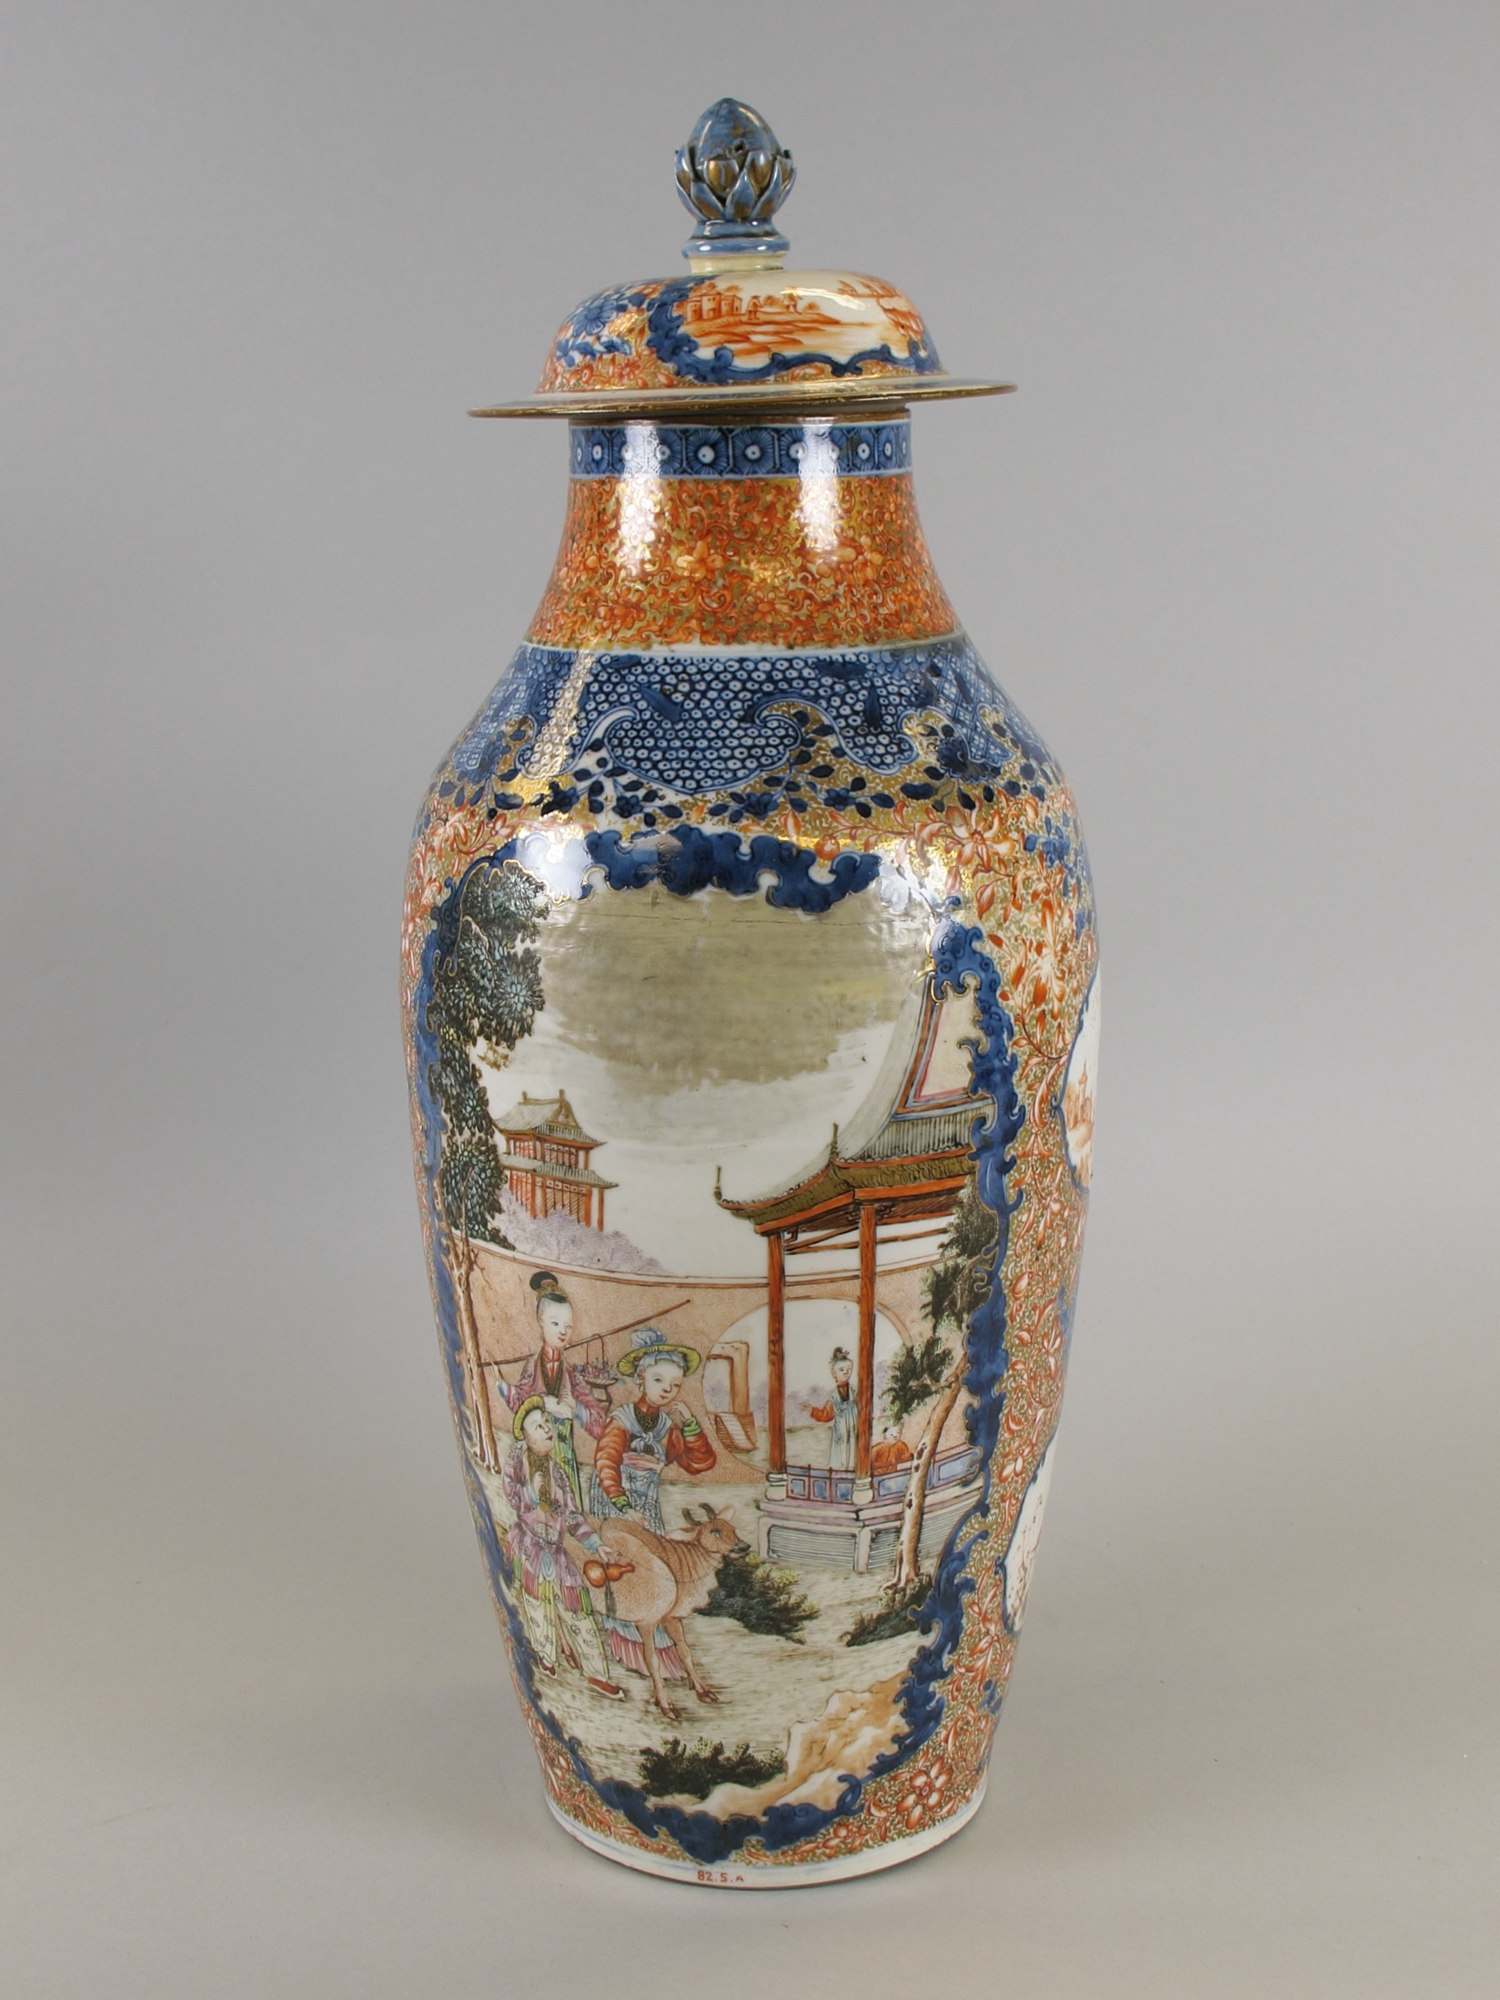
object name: covered vase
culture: chinese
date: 1801-1850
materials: enamel, porcelain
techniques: overglaze, painting, polychrome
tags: women,cows